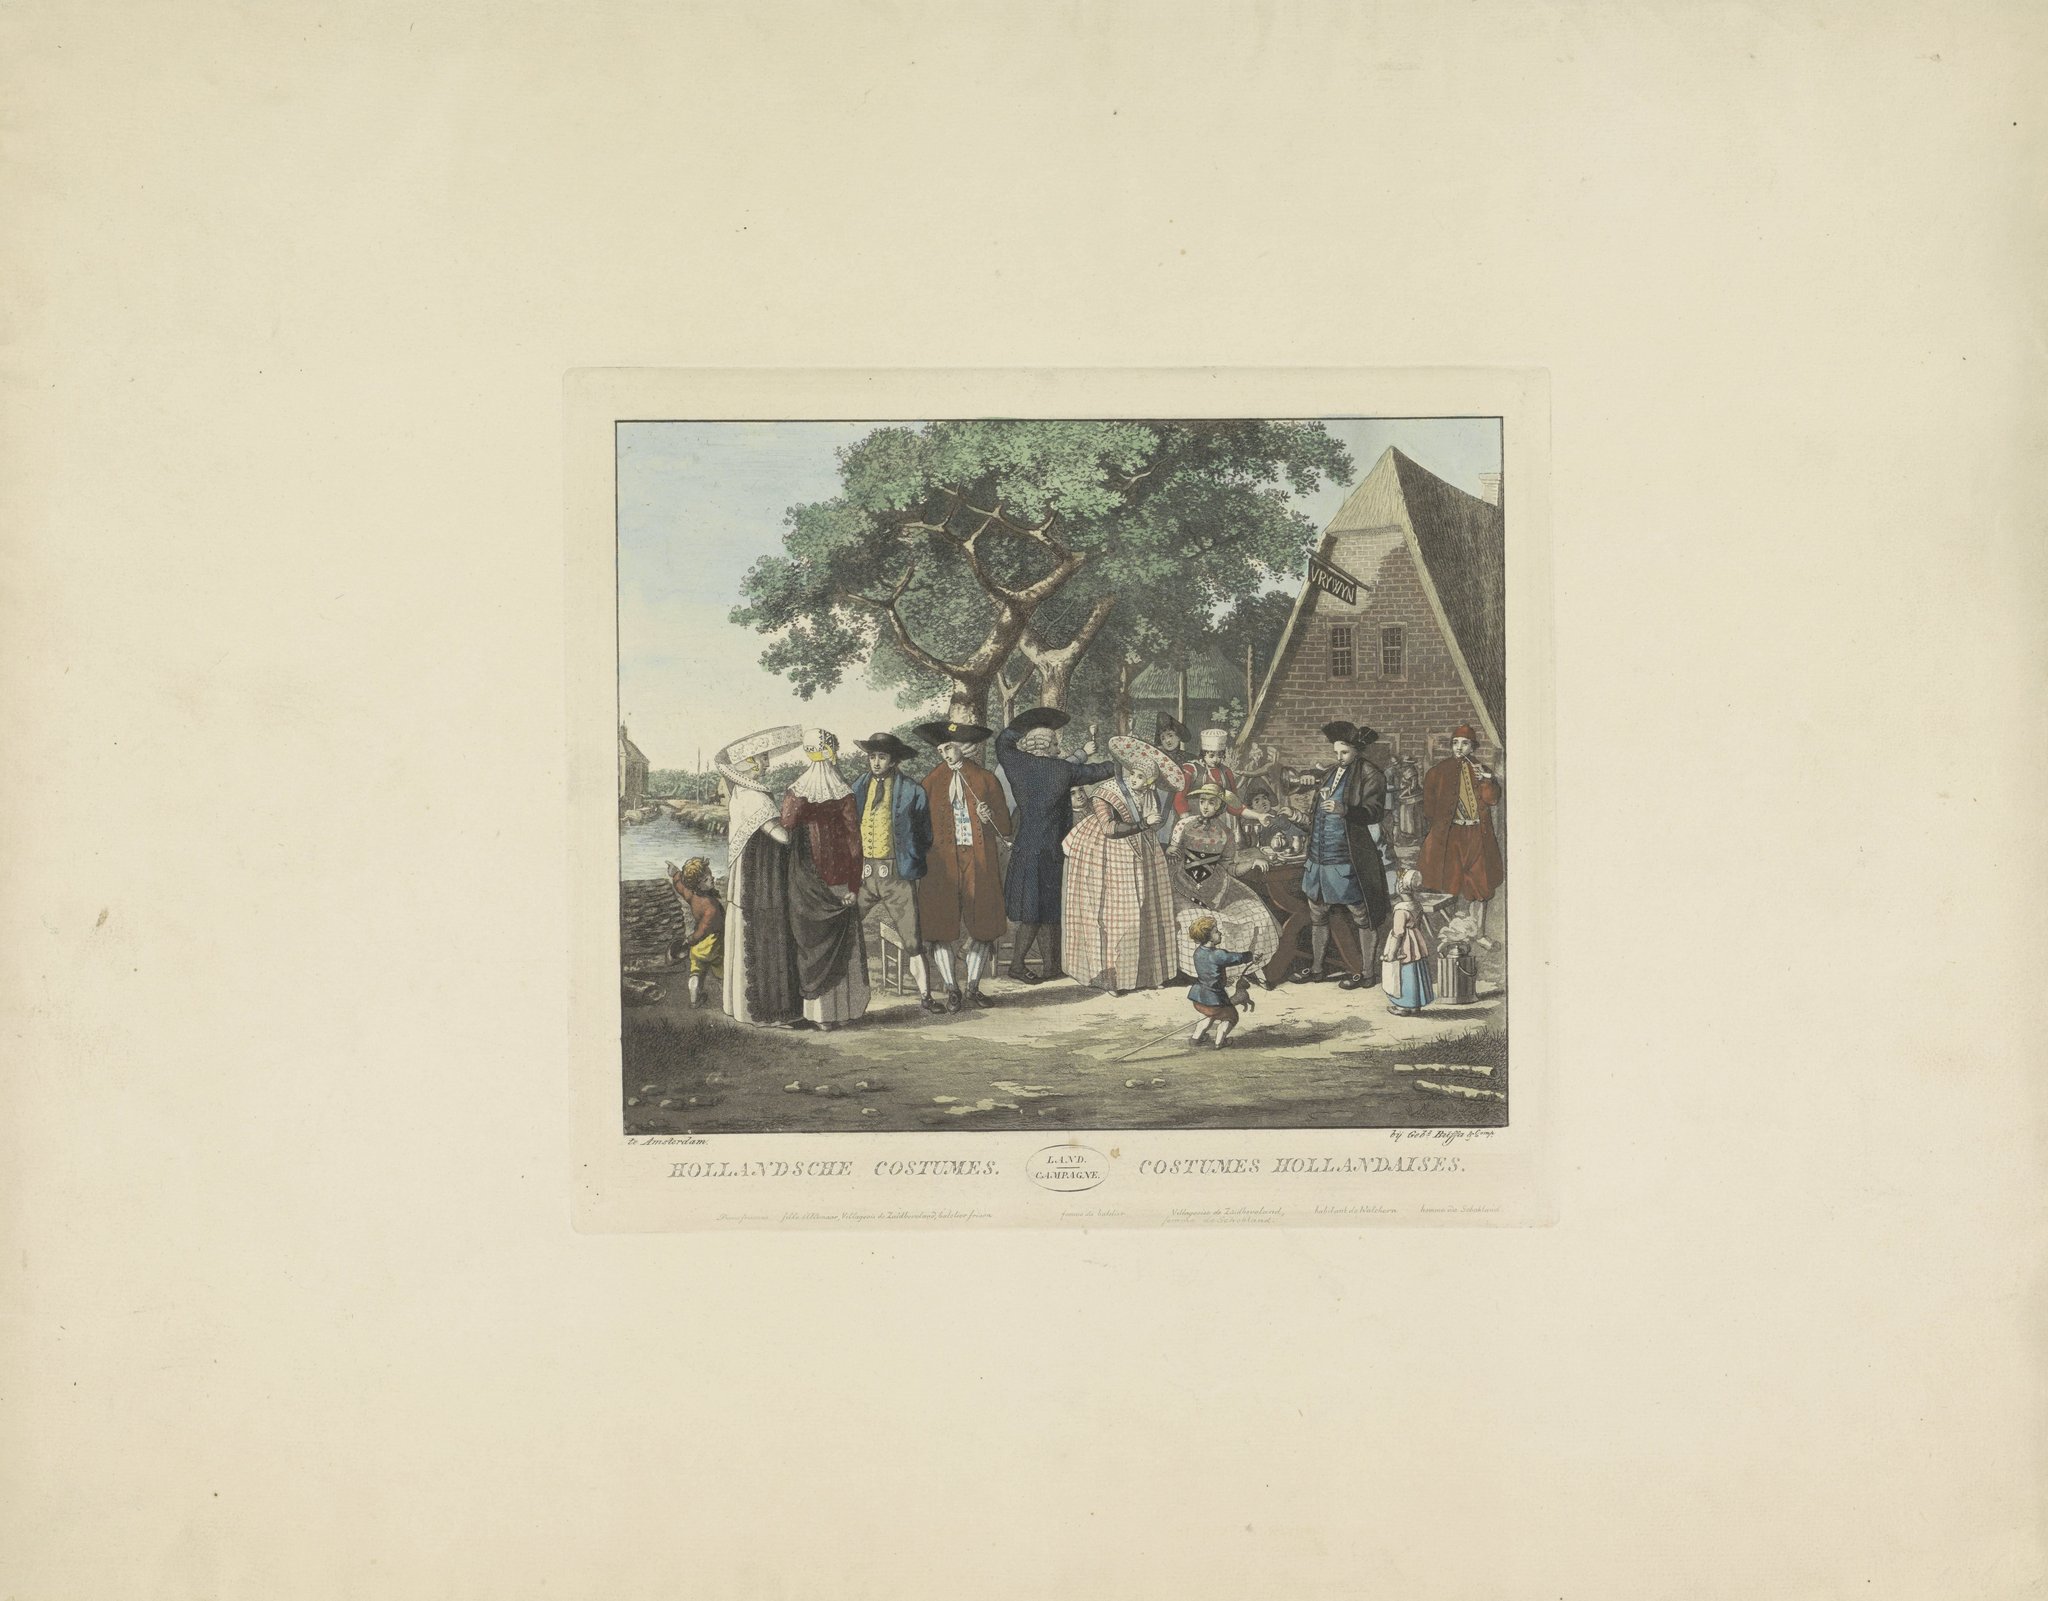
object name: costume print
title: Hollandsche Costumes. Land/Campagne. Costumes Hollandaises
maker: ludwig gottlieb portman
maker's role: print maker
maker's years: 1772-1828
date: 1820-1830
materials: paper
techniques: aquatint, etching, hand coloring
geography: netherlands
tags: professional clothes, inn, coffee-house, public house, etc., folk costume, regional costume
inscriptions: collector's mark: Lugt 2228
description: Twaalf personen in klederdracht van verschillende landstreken, verzameld voor een dorpsherberg, ca. 1820-1830. Volgens de opschriften onder de titel gaat het om personen uit de streken Friesland, Alkmaar, Zuid-Beveland, Schokland en Walcheren. Zie ook de pendant.